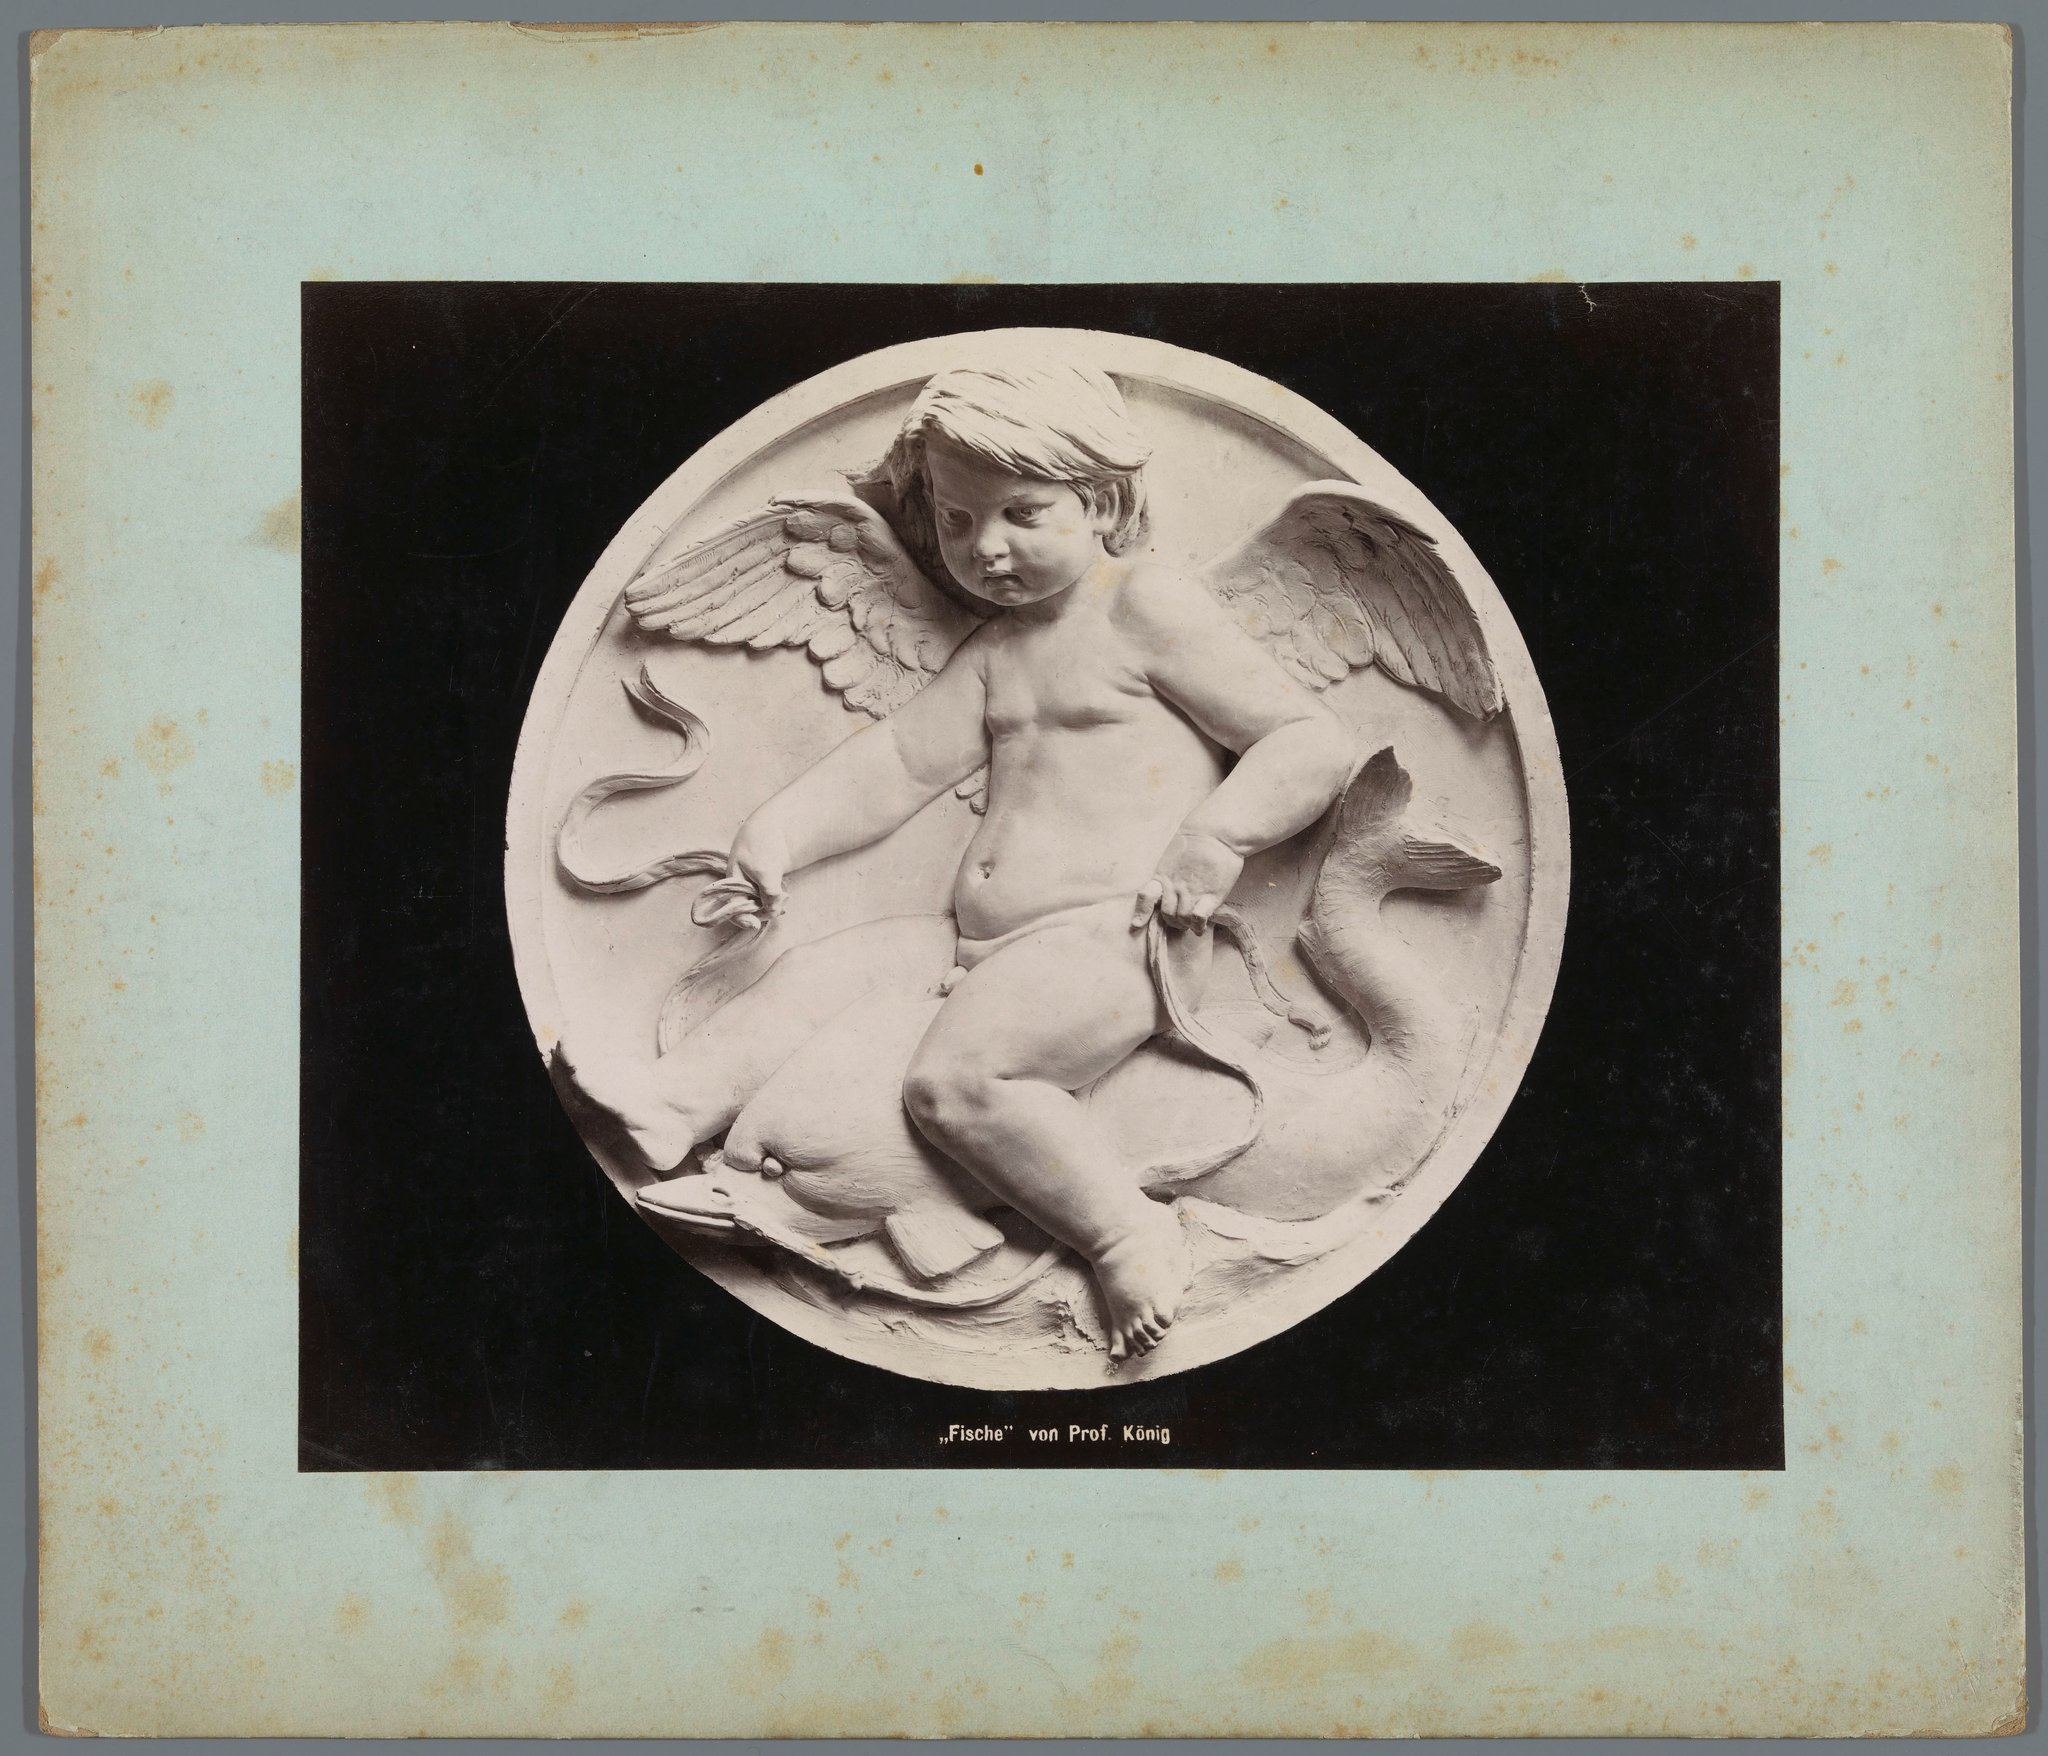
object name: photograph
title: Reliëf van een putto op een zeedier, mogelijk een dolfijn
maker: josef löwy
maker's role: publisher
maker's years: 1835-1902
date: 1875-1900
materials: cardboard, photographic support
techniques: albumen print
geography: europe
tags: fishes, cupids: 'amores', 'amoretti', 'putti', sculpture (+ relief ~ sculpture), europe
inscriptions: collector's mark: Lugt 3937